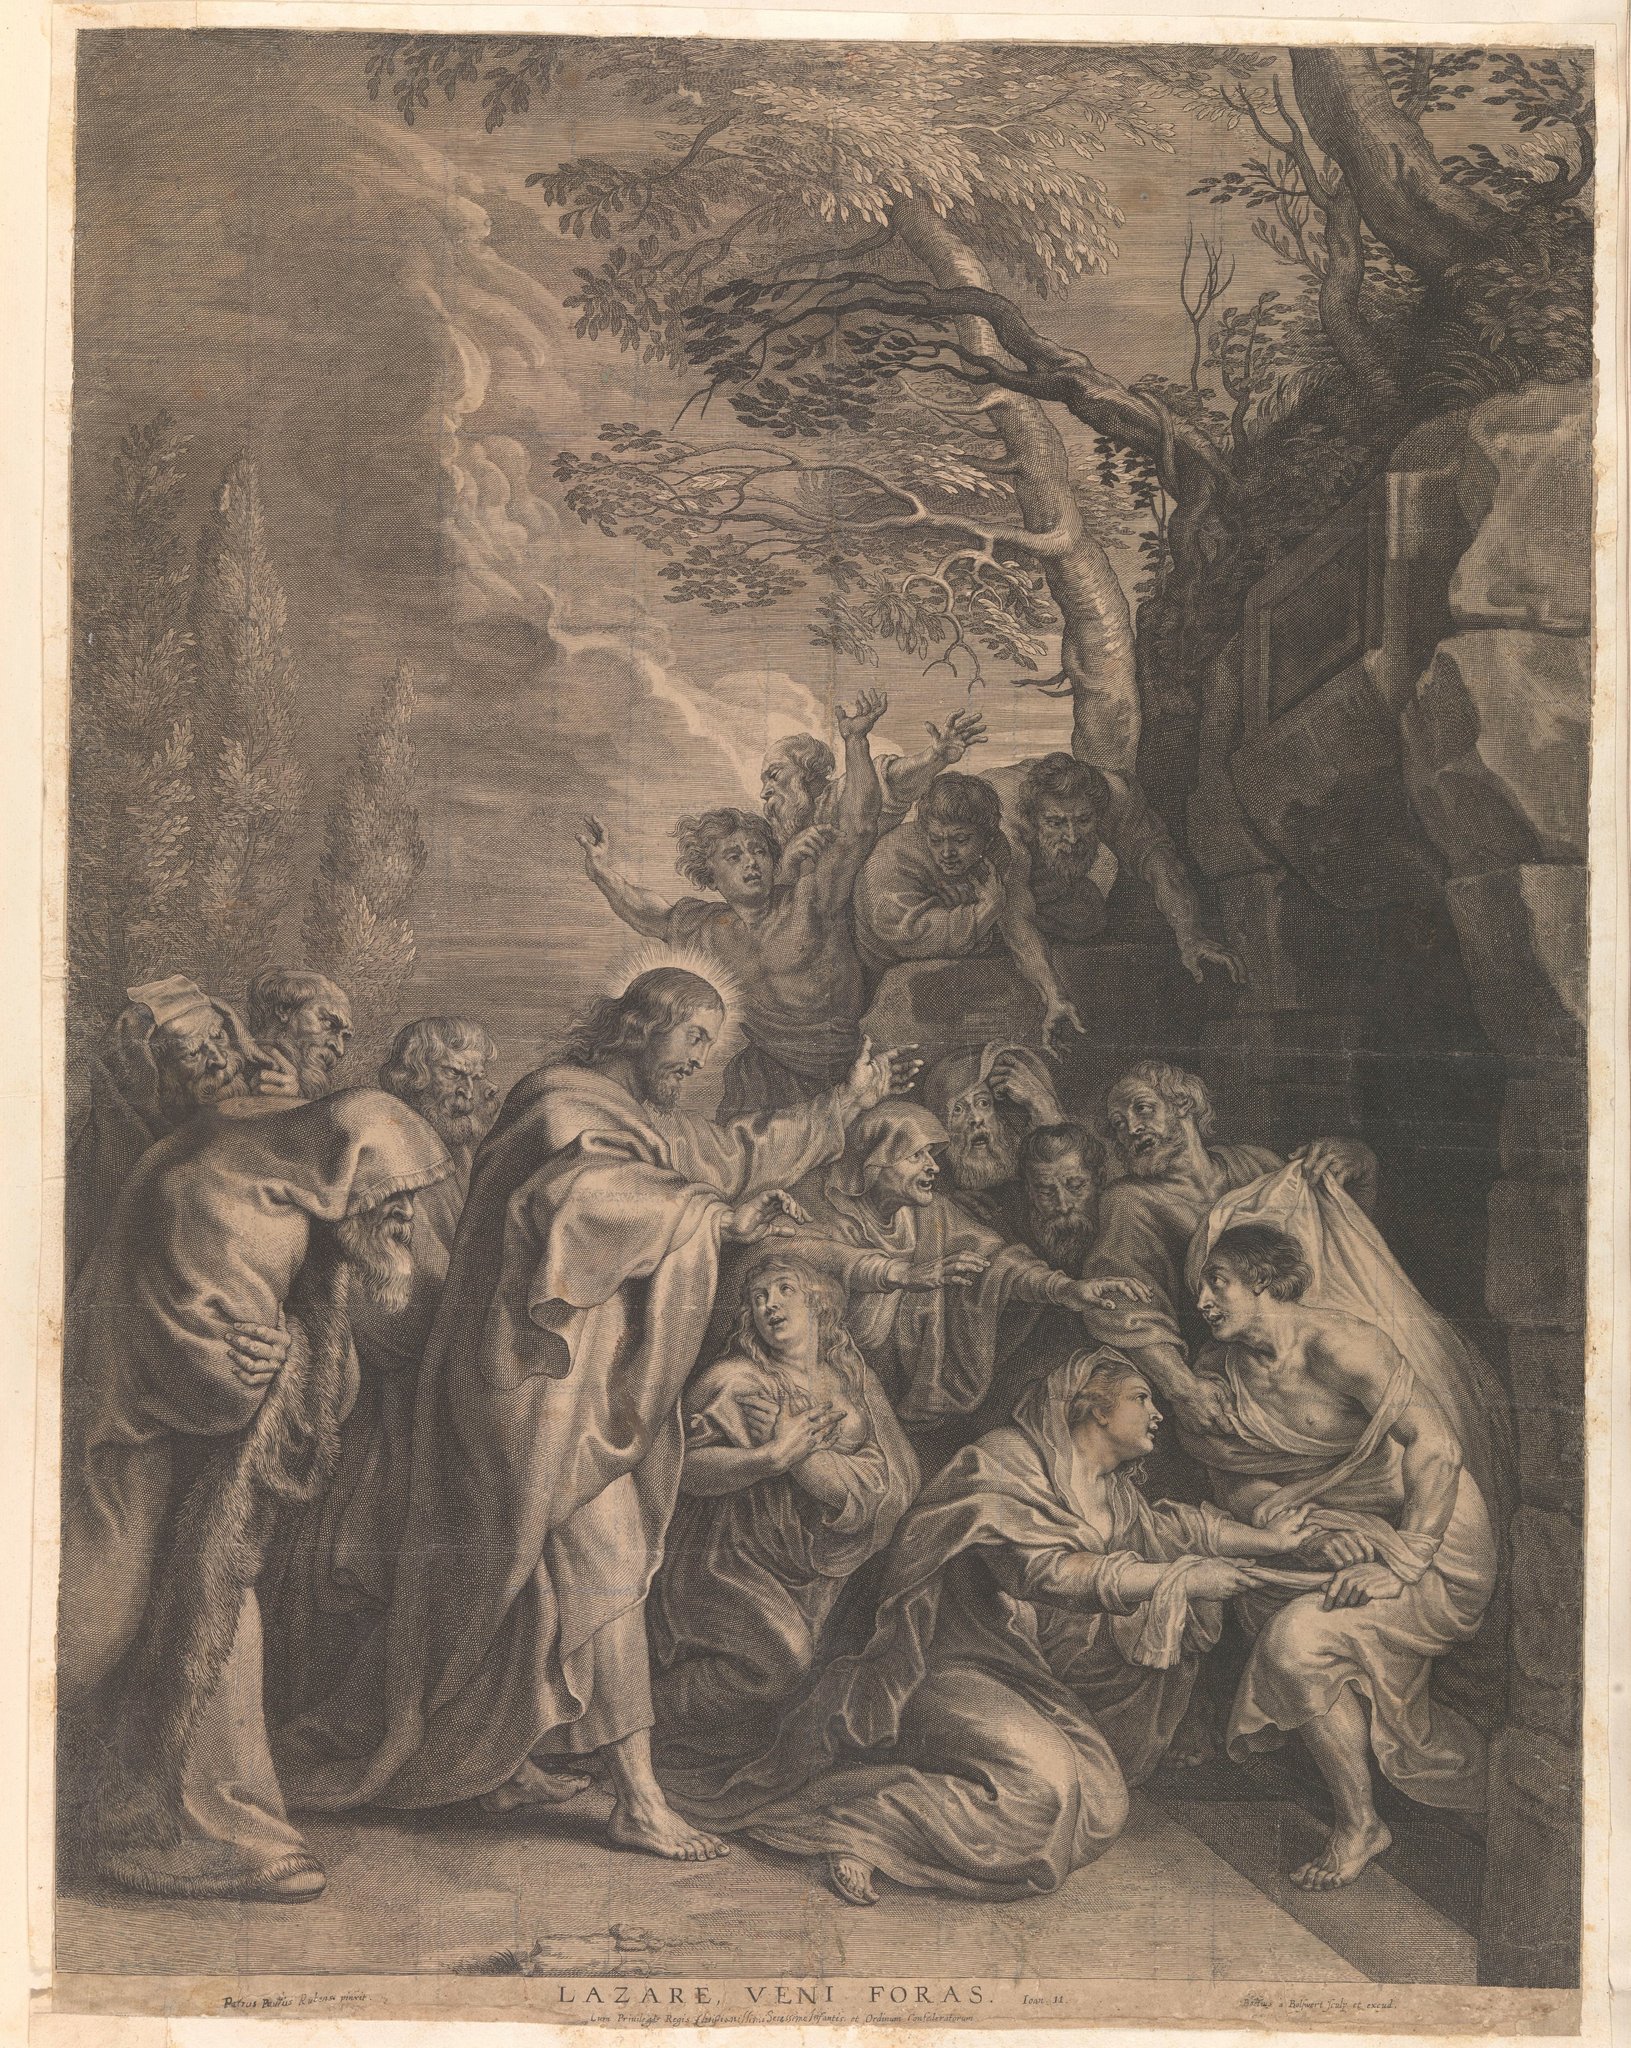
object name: print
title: Lazare, veni foras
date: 1621-1633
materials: paper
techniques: engraving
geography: southern netherlands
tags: the raising of lazarus ('lazarus, come out')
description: Opwekking van Lazarus, een wonder verricht door Christus (Joh 11). Deze prent maakt deel uit van een album.